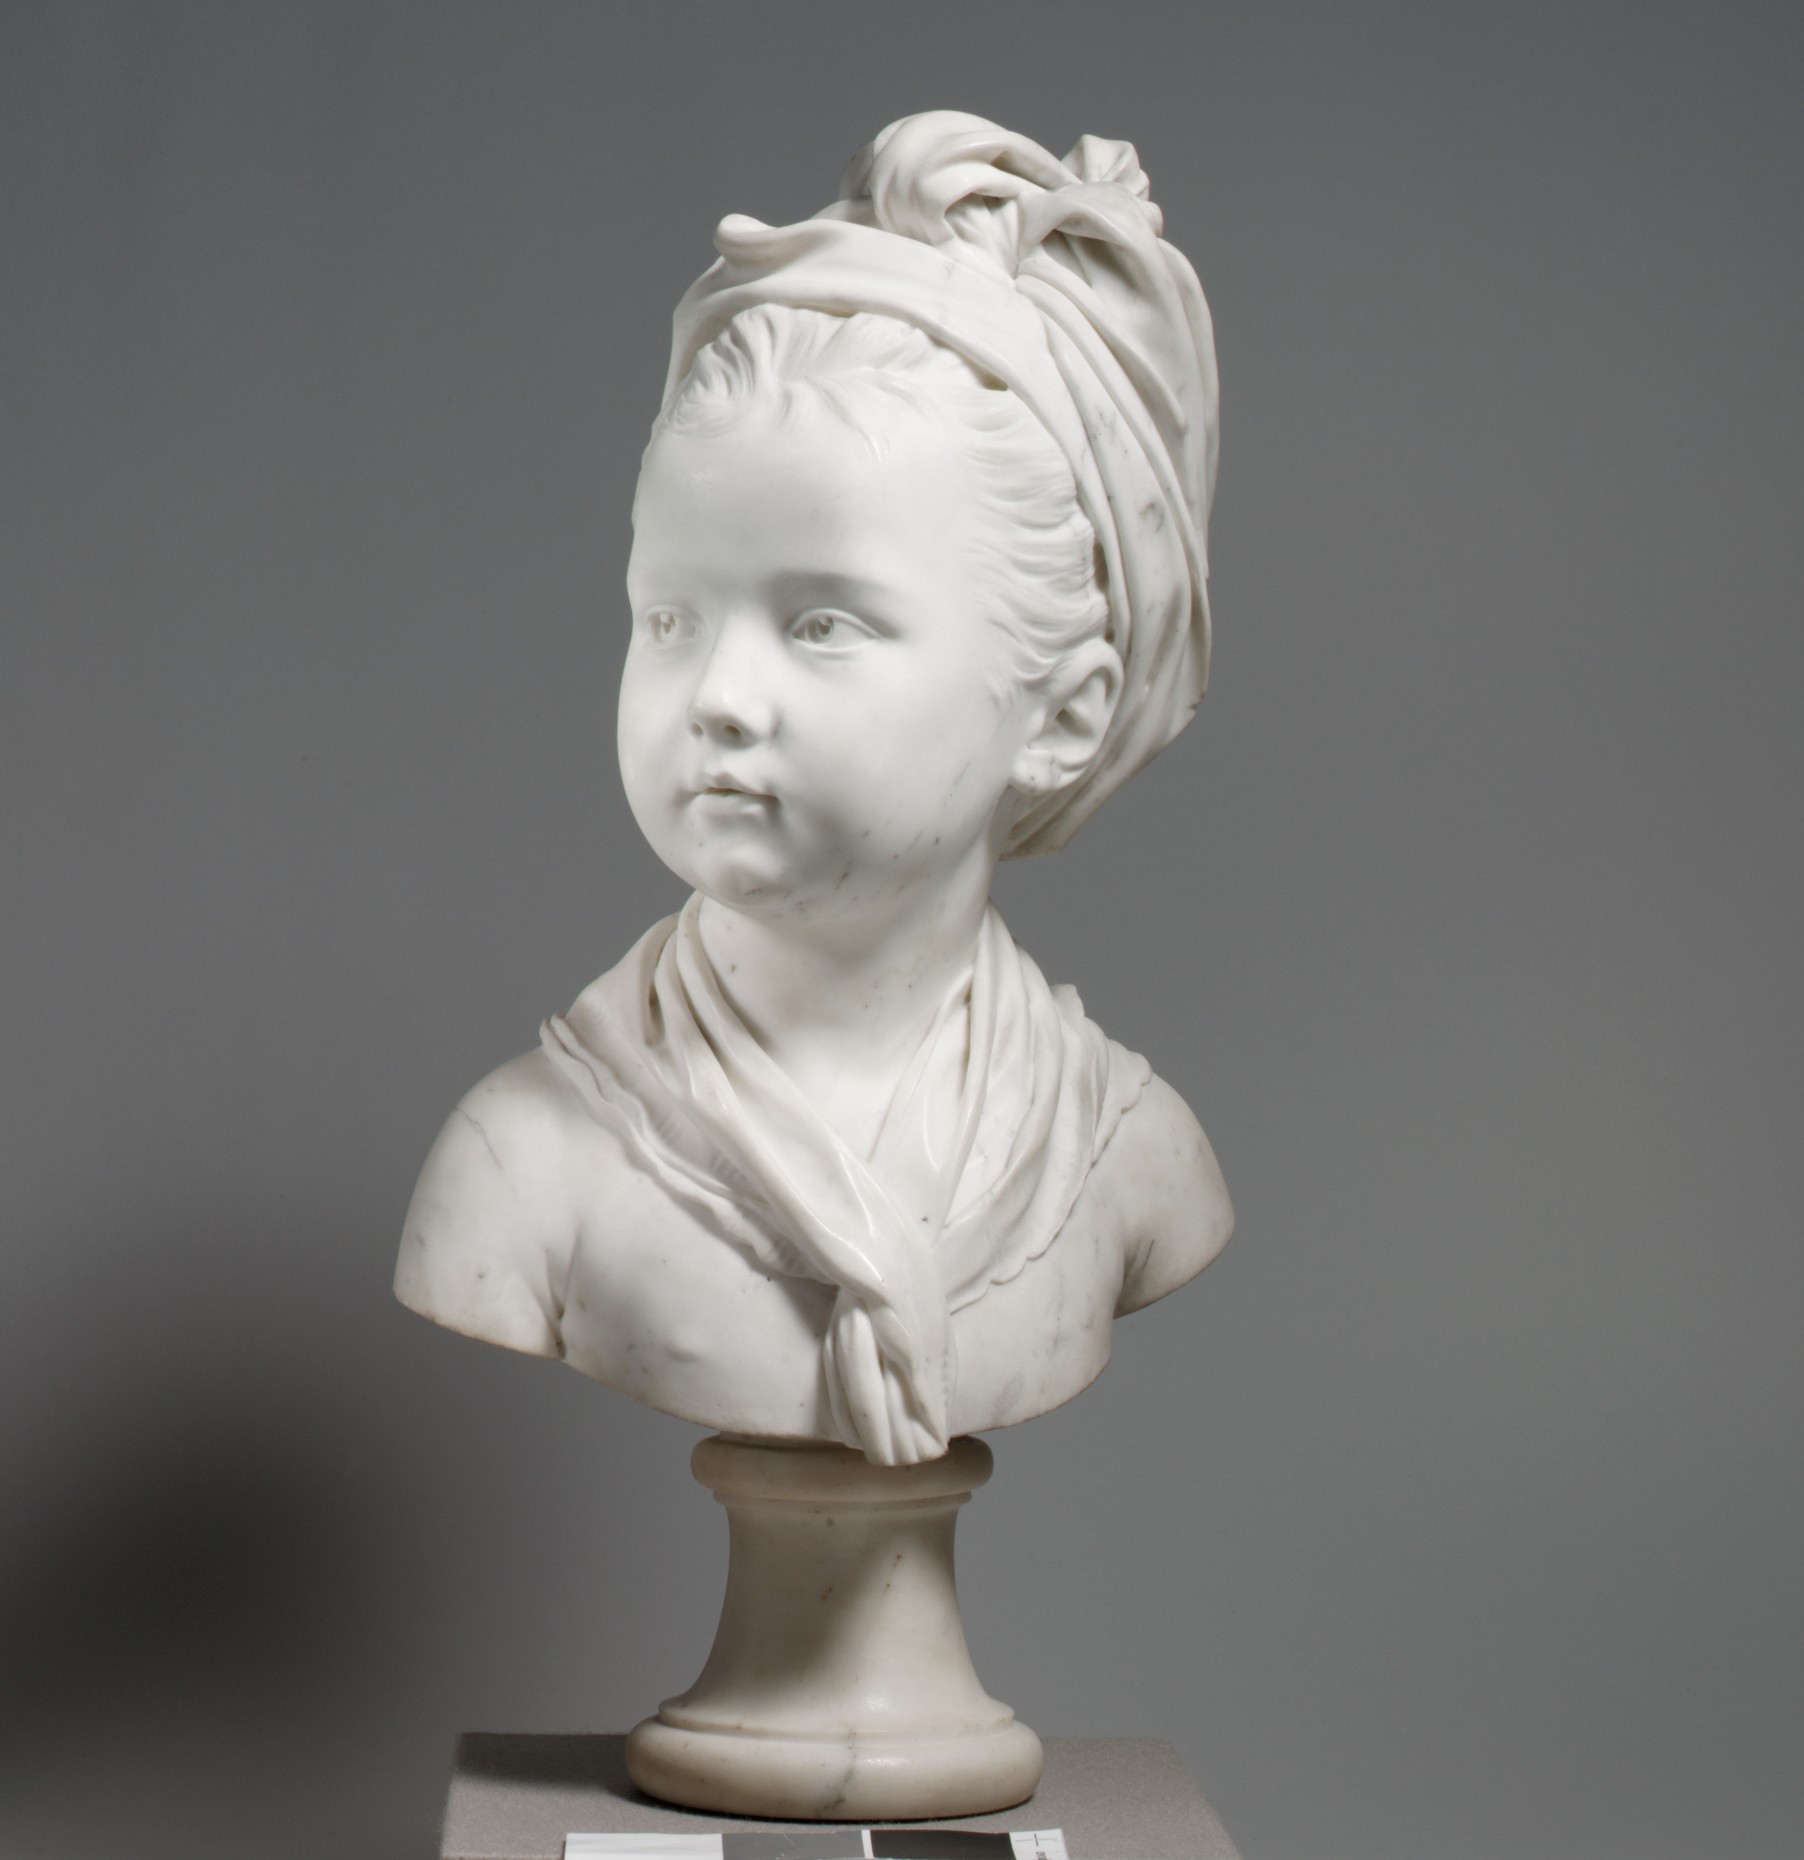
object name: bust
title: Louise Brongniart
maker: jean antoine houdon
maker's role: artist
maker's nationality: french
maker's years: 1741-1828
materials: marble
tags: girls,portraits